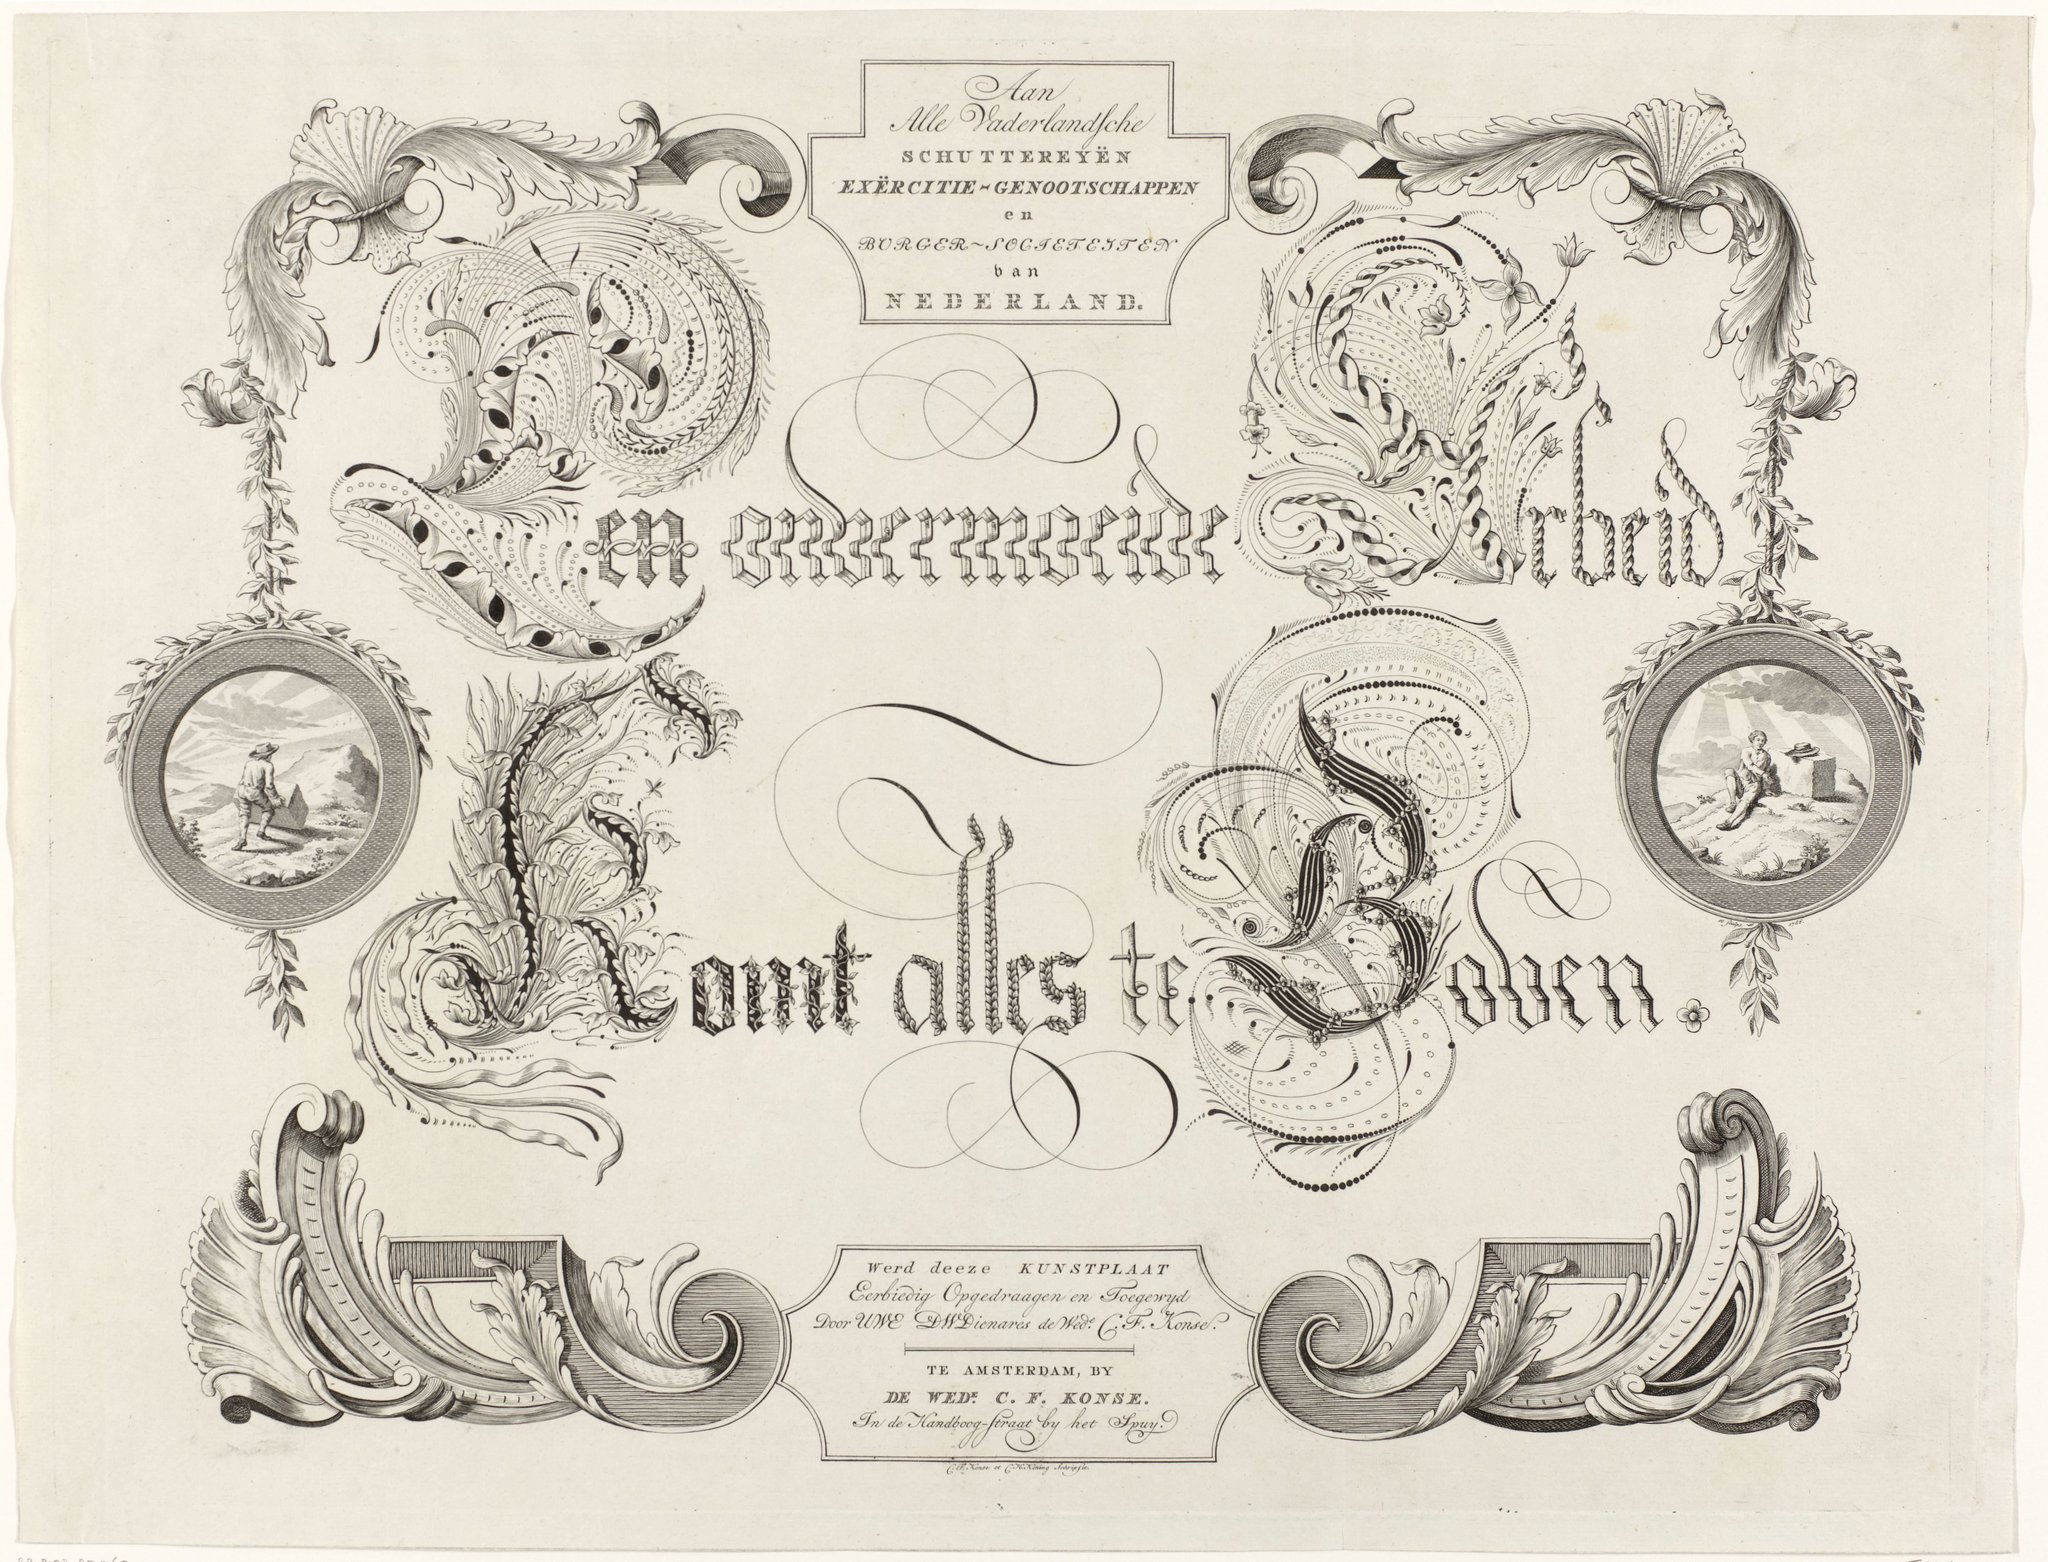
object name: print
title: Een onvermoeide arbeid komt alles te boven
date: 1786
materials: paper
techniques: engraving, etching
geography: northern netherlands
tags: calligraphy, amsterdam, patriots (1780-1795)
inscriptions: collector's mark: Lugt 2228, dedication: ‘Aan Alle Vaderlandsche Schuttereijen Exërcitie-Genootschappen en Burger-Societeiten van Nederland./ Werd deeze Kunstplaat Eerbiedig Opgedragen en Toegewyd Door Uwe DWDienares de Wede. C.F. Konse.’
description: Kalligrafie met de spreuk "Een onvermoeide arbeid komt alles te boven" en twee kleine allegorische vignetten waarin een man een rotsblok een heuvel opwentelt. De spreuk is van toepassing op de oprichters van het Amsterdamse exercitiegenootschap Tot Nut der Schuttery, 1786.